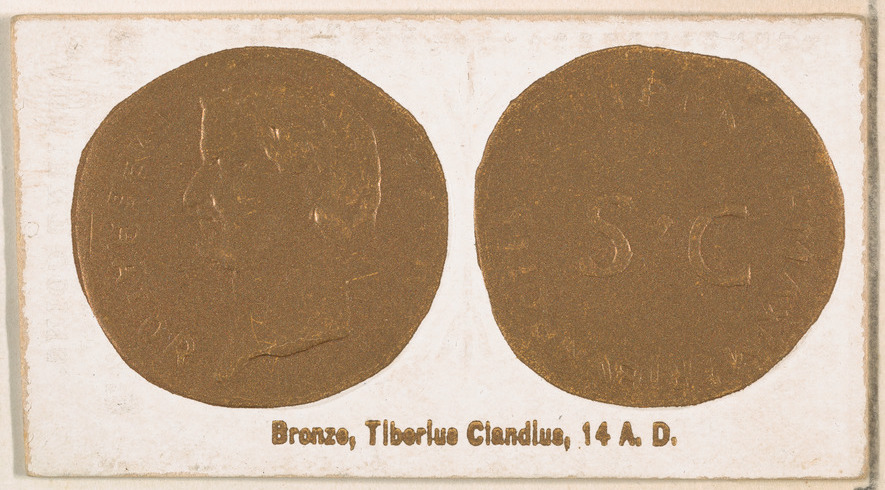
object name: print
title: Bronze, Tiberius Claudius, 14 A.D., from the Ancient Coins series (N180) issued by Wm. S. Kimball & Co.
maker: william s. kimball & company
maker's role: publisher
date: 1888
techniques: color lithograph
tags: coins